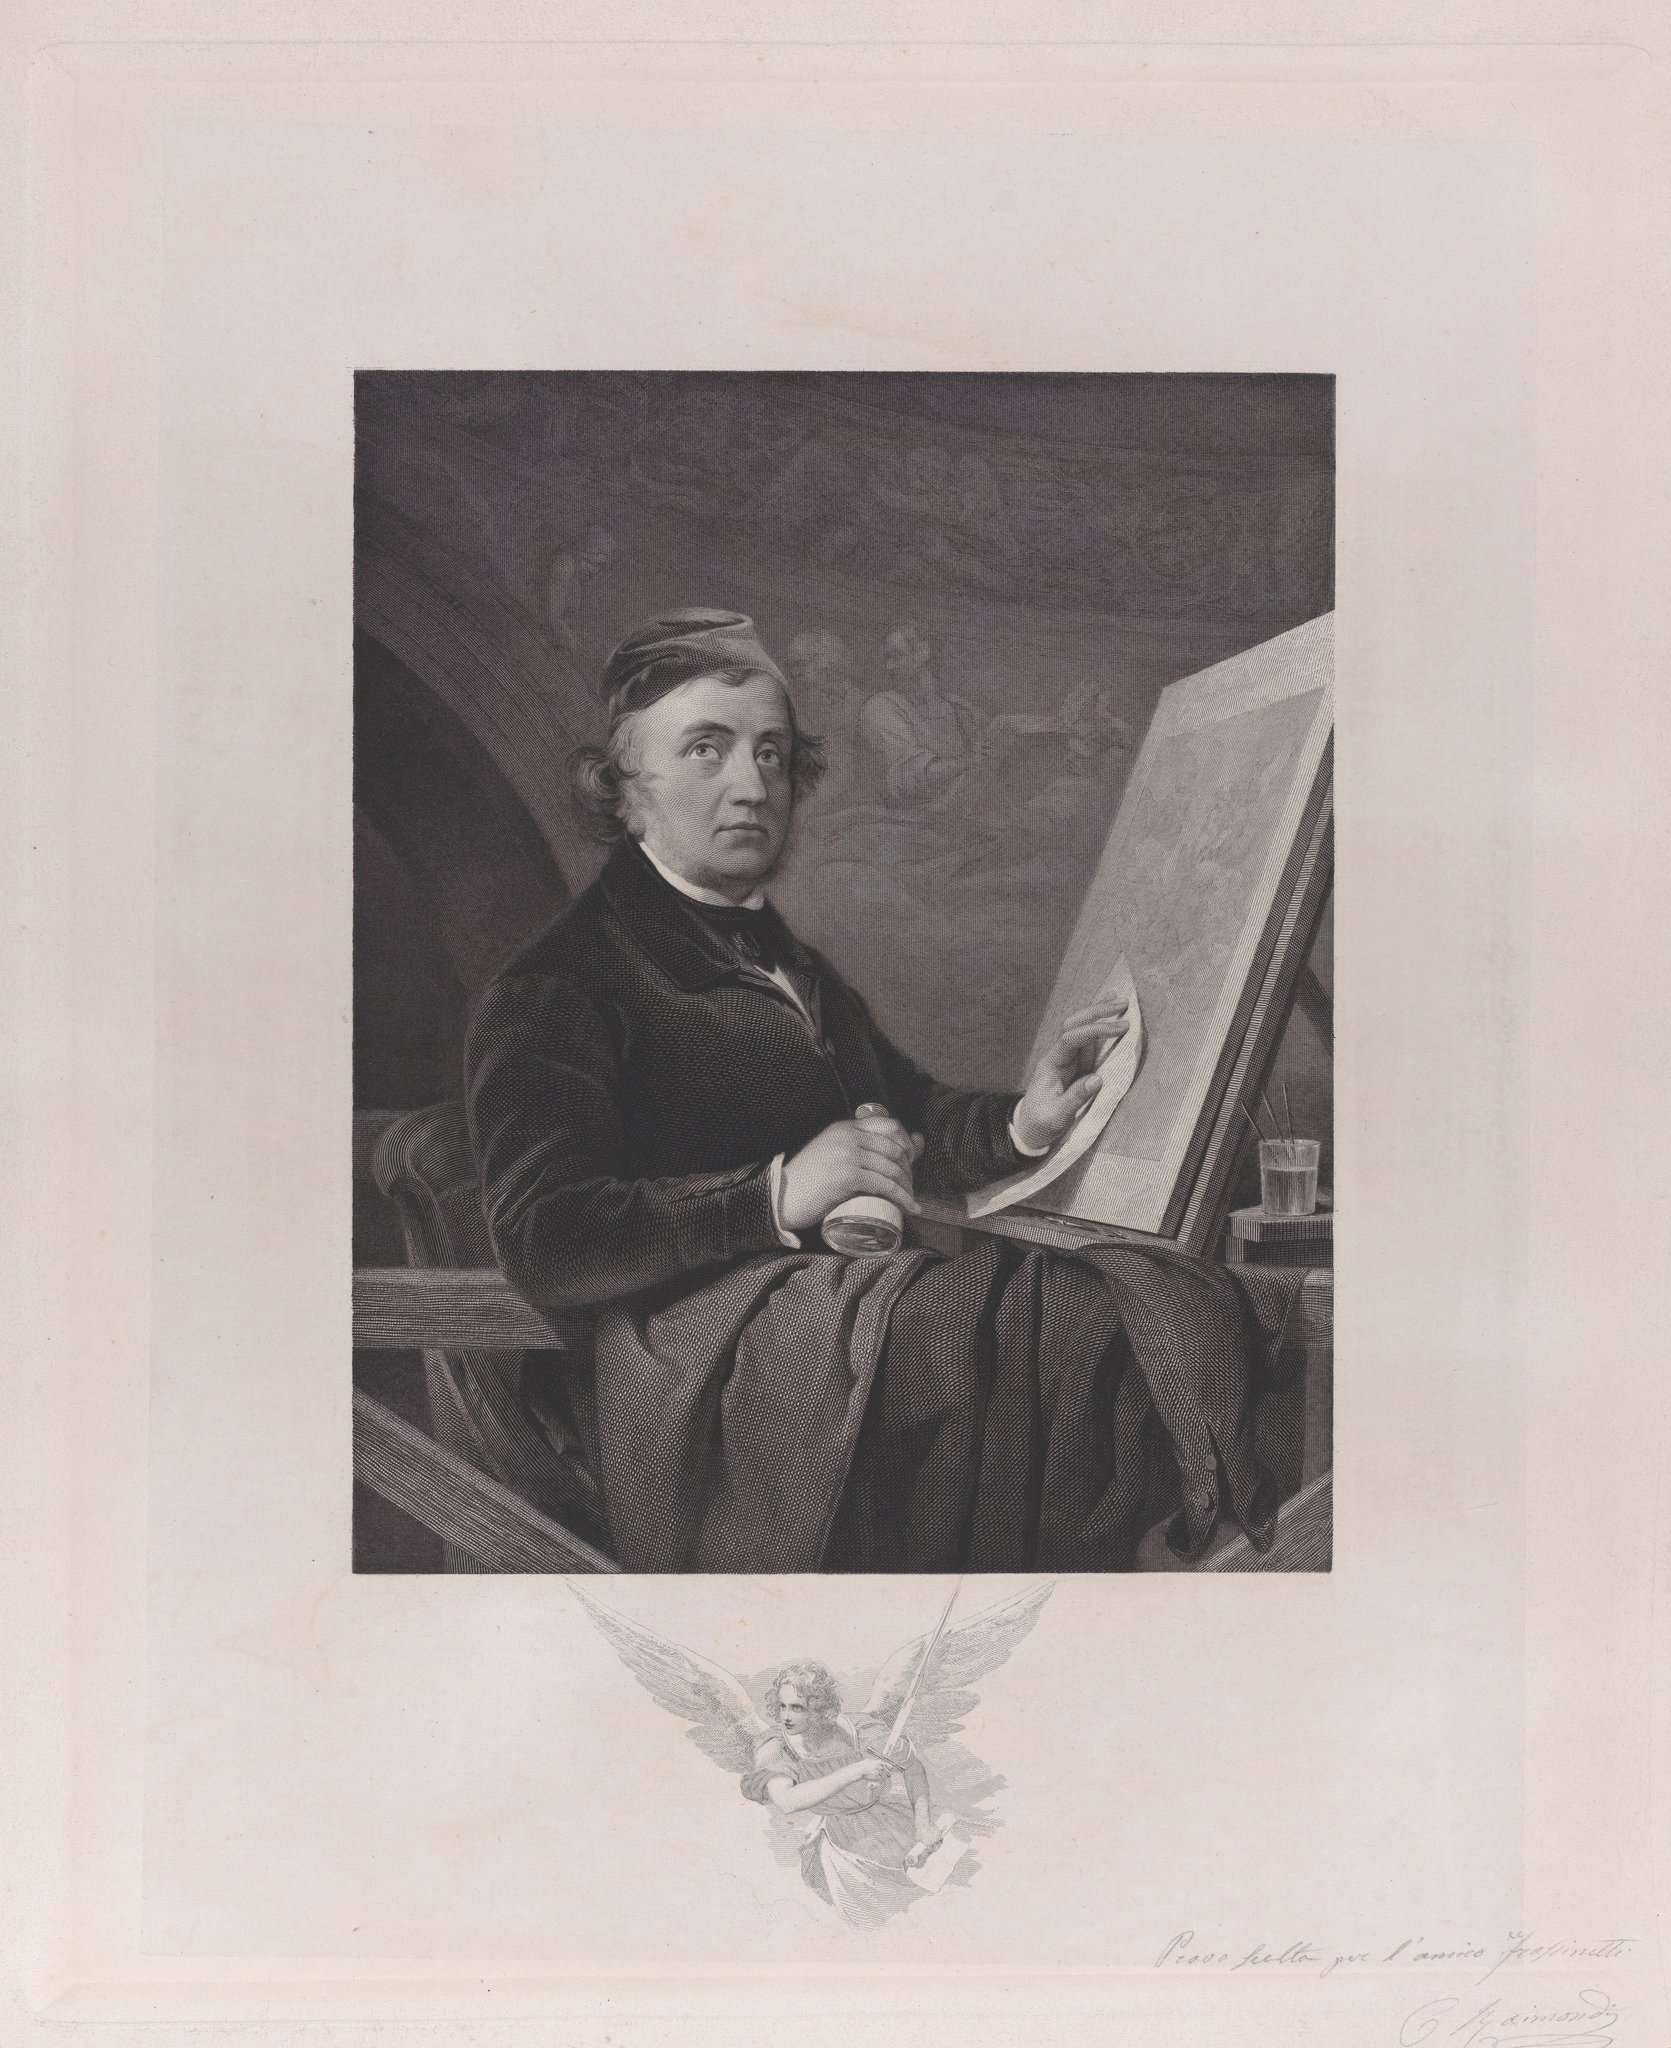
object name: print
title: Portrait of Paolo Toschi, seated at an easel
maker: carlo raimondi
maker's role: artist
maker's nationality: italian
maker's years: 1809-1883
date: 1830-1883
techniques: engraving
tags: men,portraits,artists,easels